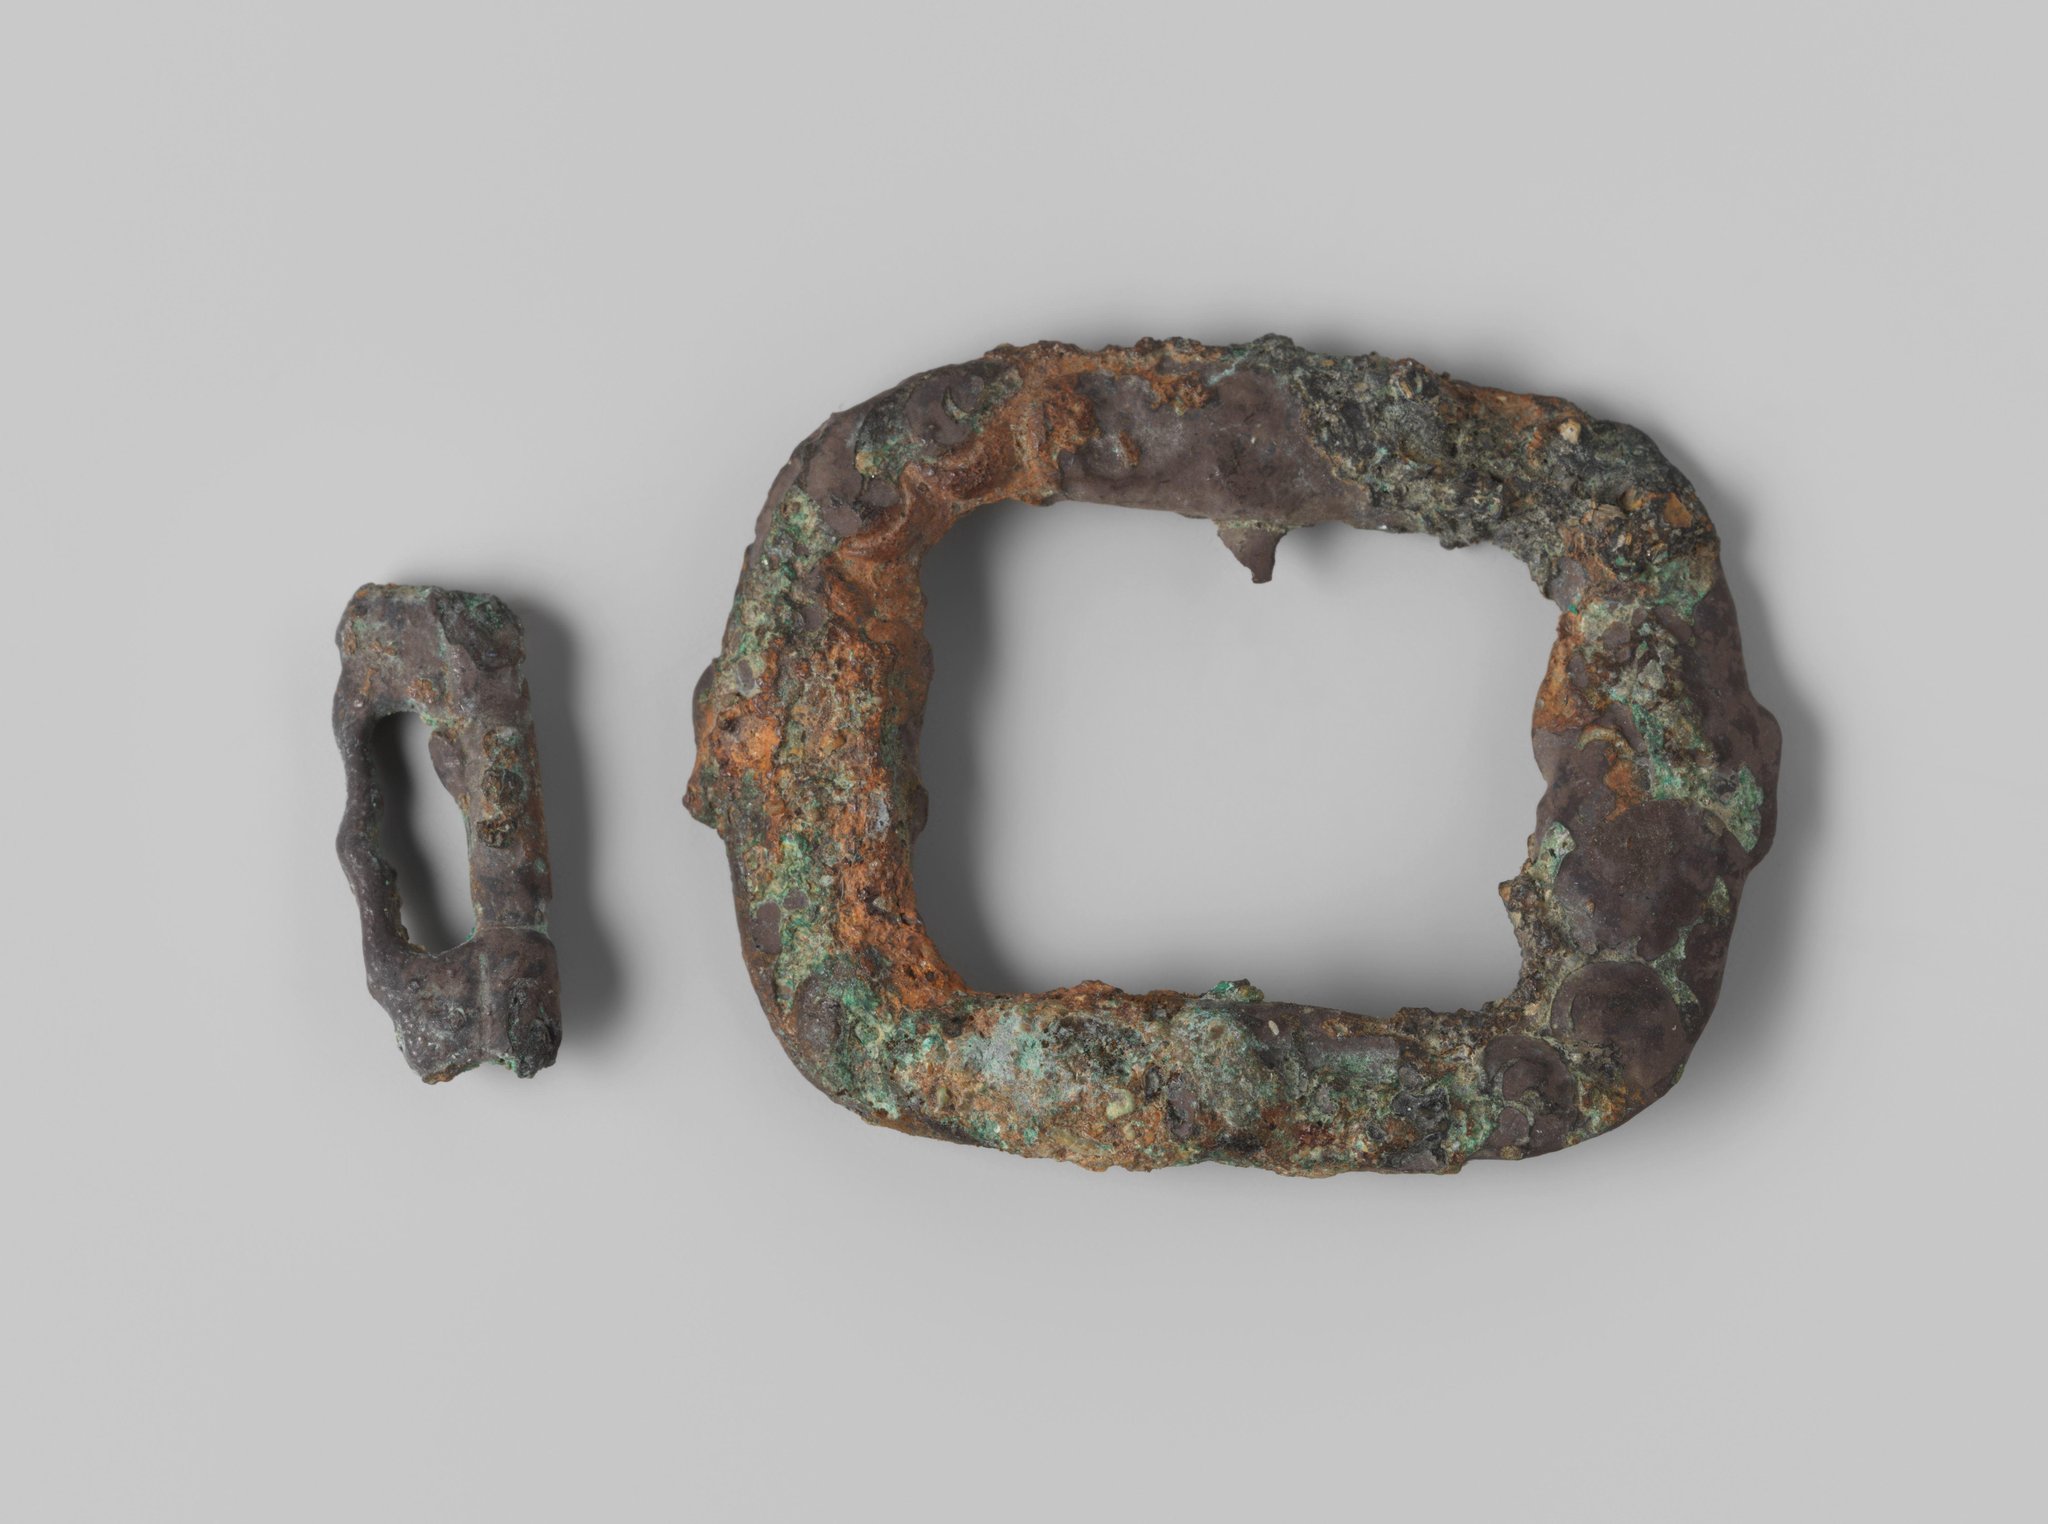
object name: shoe buckle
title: Fragmenten schoengesp uit het wrak van de Oost-Indiëvaarder Hollandia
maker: Anonymous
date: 1700-1743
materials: silver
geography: netherlands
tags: verenigde oostindische compagnie, hollandia (schip), annet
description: Buckle, chape buckle, shoe buckle; fragment ring, corroded, with spindle, scrolling moulding with projection on short sides sim. NG 1980-27H3283.